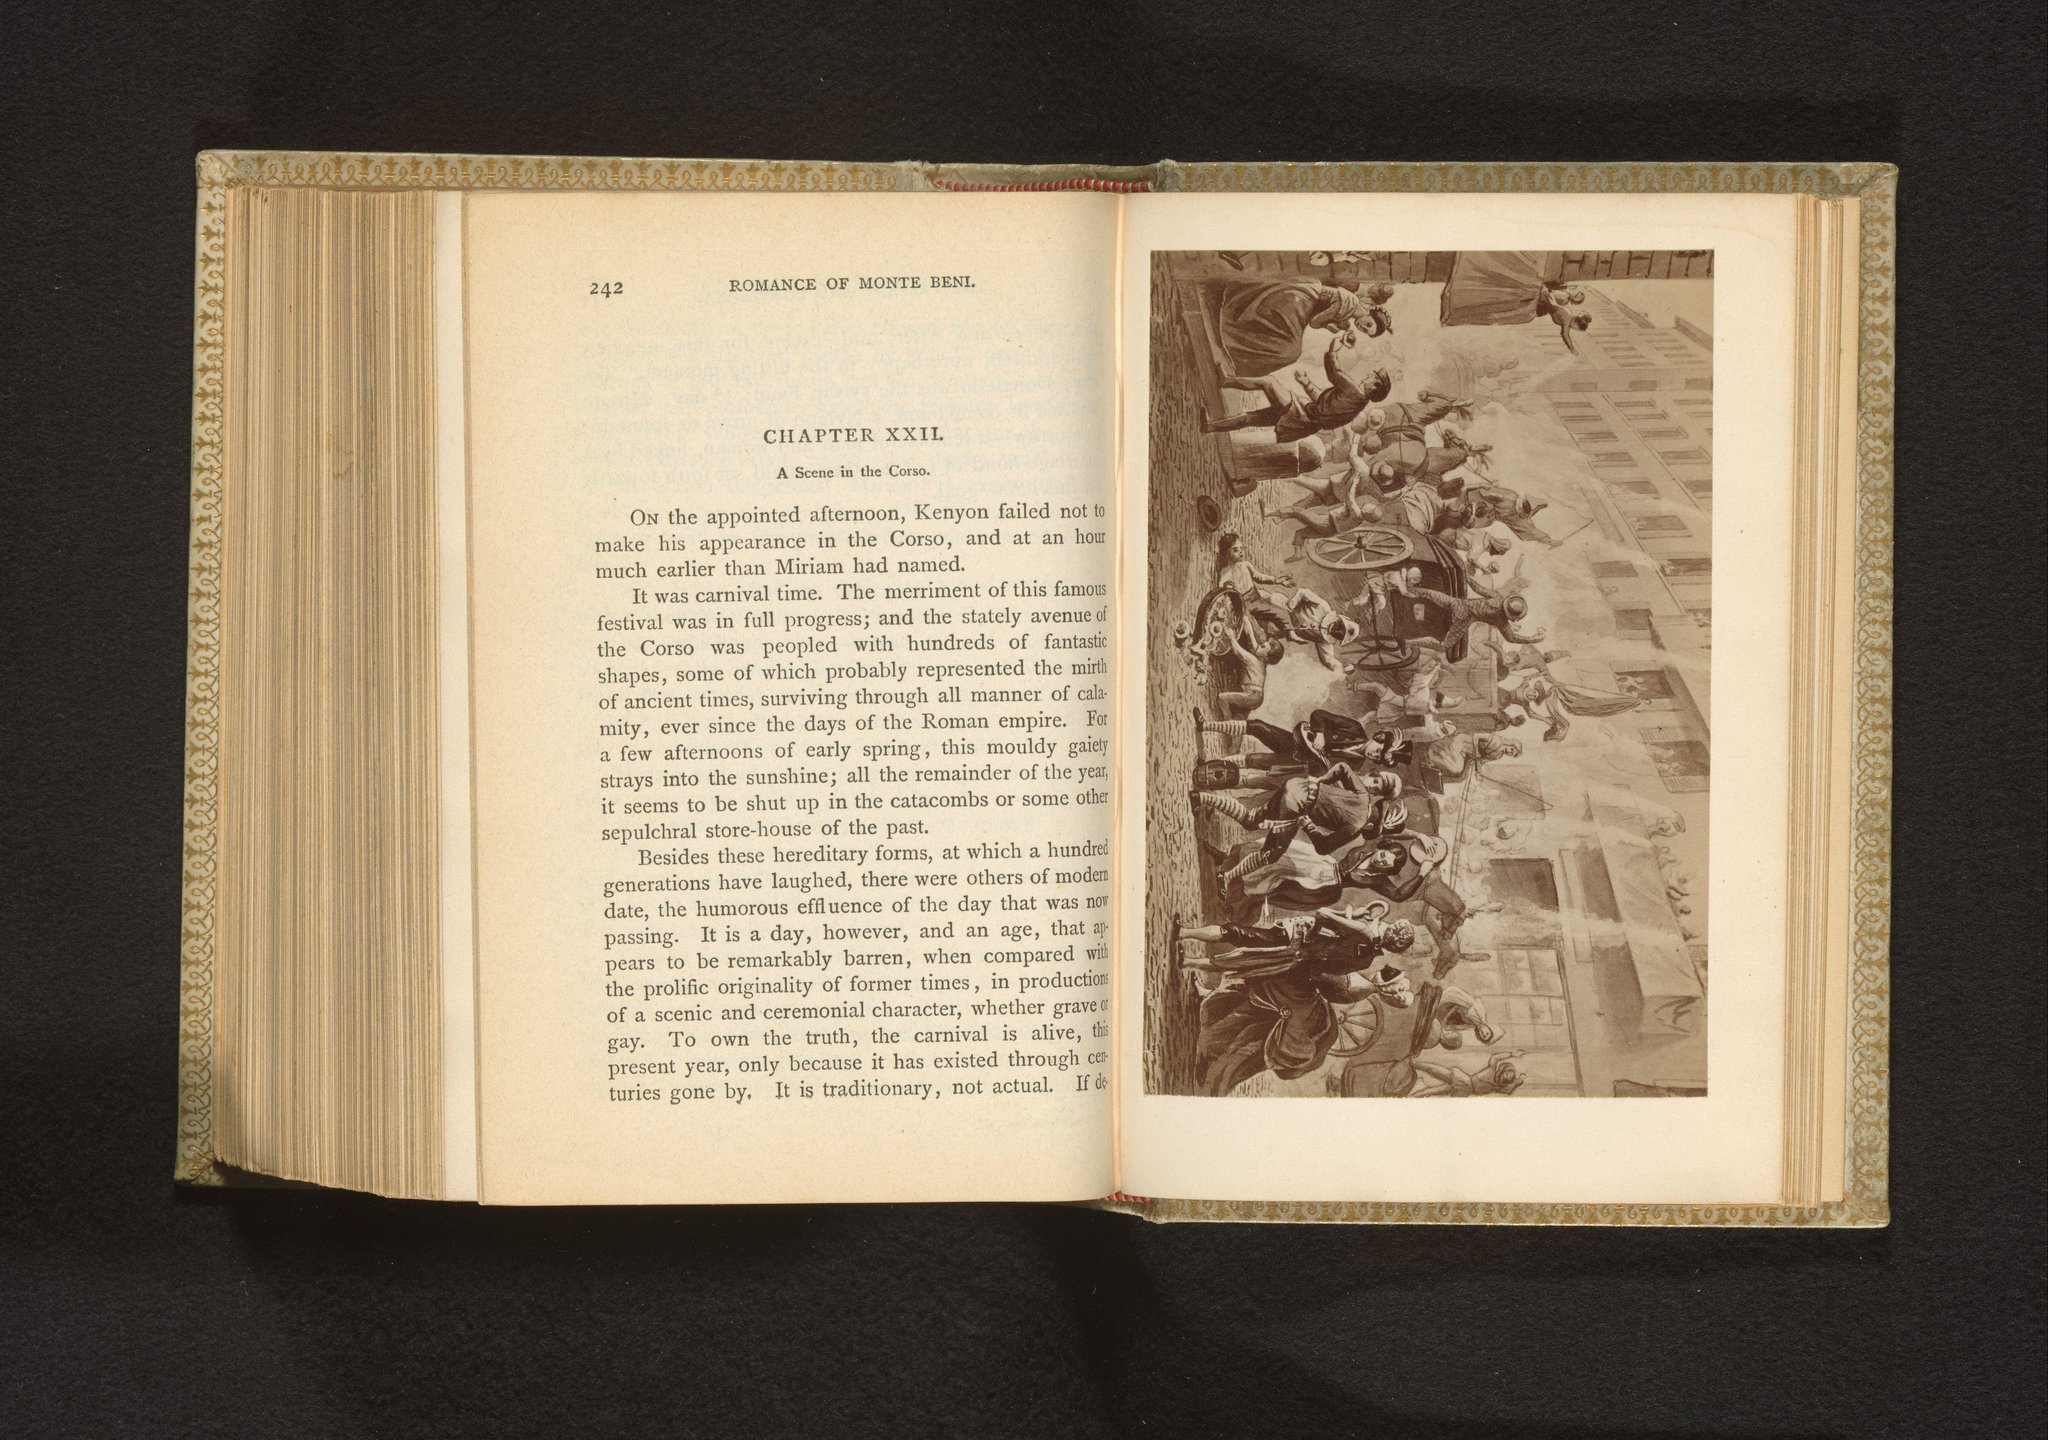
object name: photograph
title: Fotoreproductie van een tekening van carnaval in Via del Corso in Rome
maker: Anonymous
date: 1850-1860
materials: photographic support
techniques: albumen print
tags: periodic celebrations, popular feasts